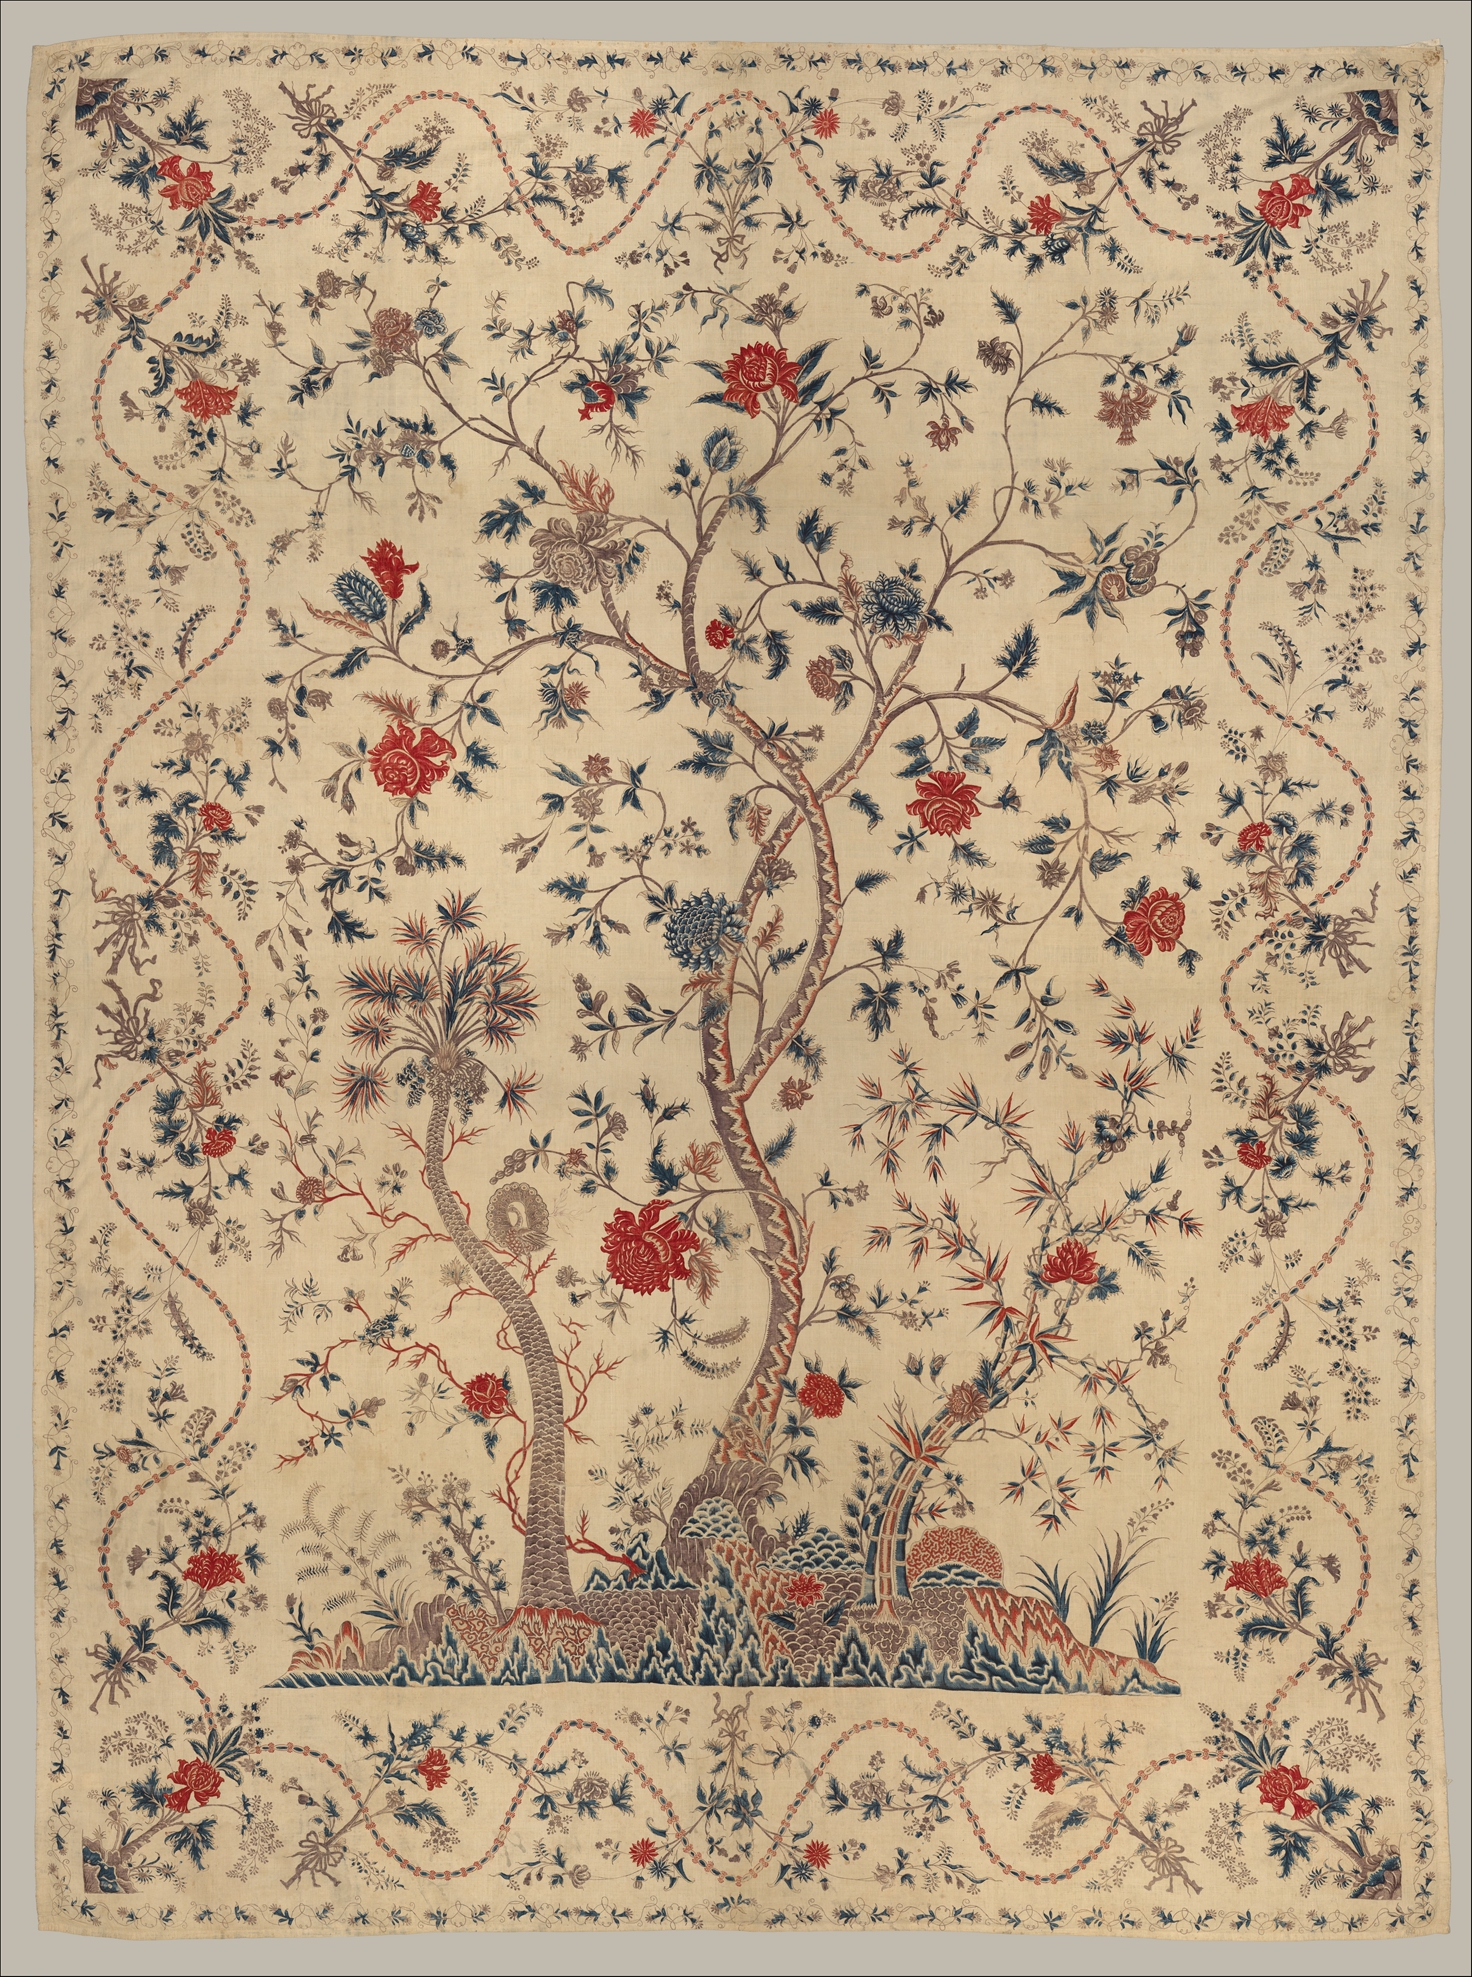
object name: hanging or bed cover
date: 1767-1800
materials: cotton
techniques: painting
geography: india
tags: flowers,trees